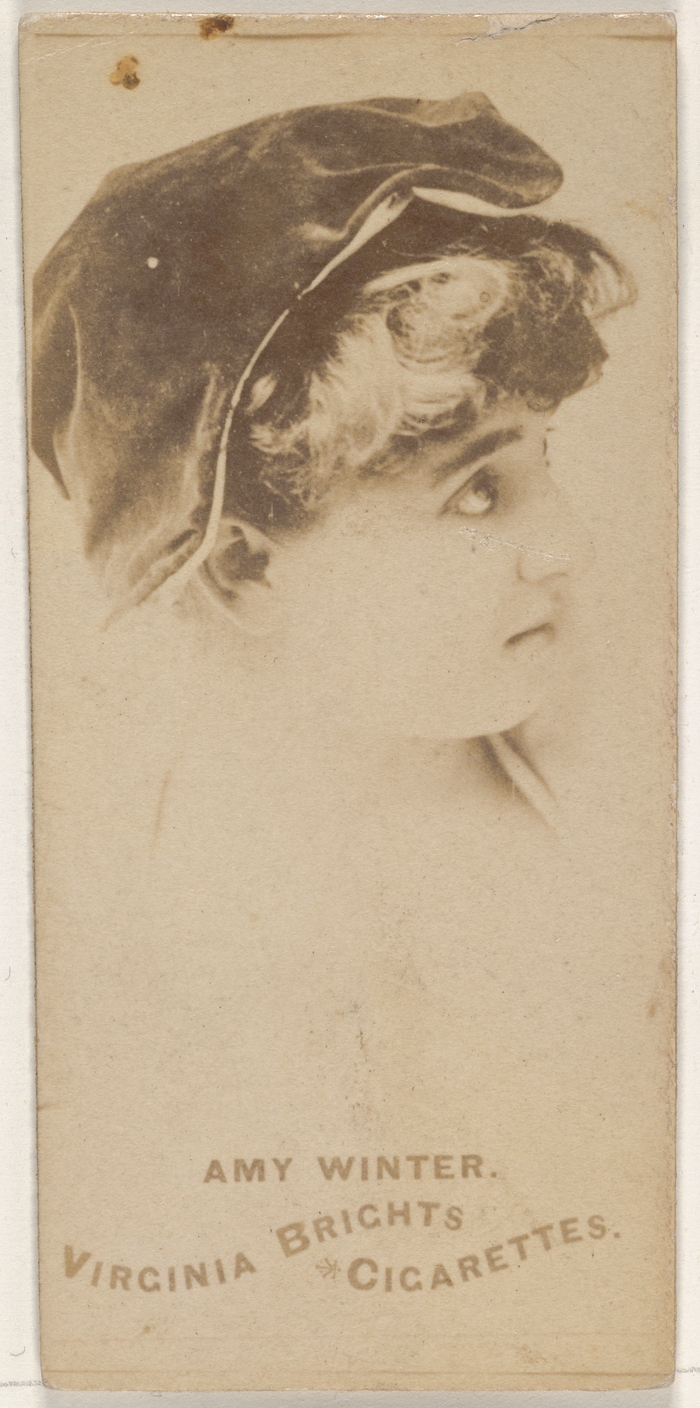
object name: photograph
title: Amy Winter, from the Actors and Actresses series (N45, Type 1) for Virginia Brights Cigarettes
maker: allen & ginter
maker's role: publisher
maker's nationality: american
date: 1888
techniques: albumen silver print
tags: portraits,profiles,women,actresses